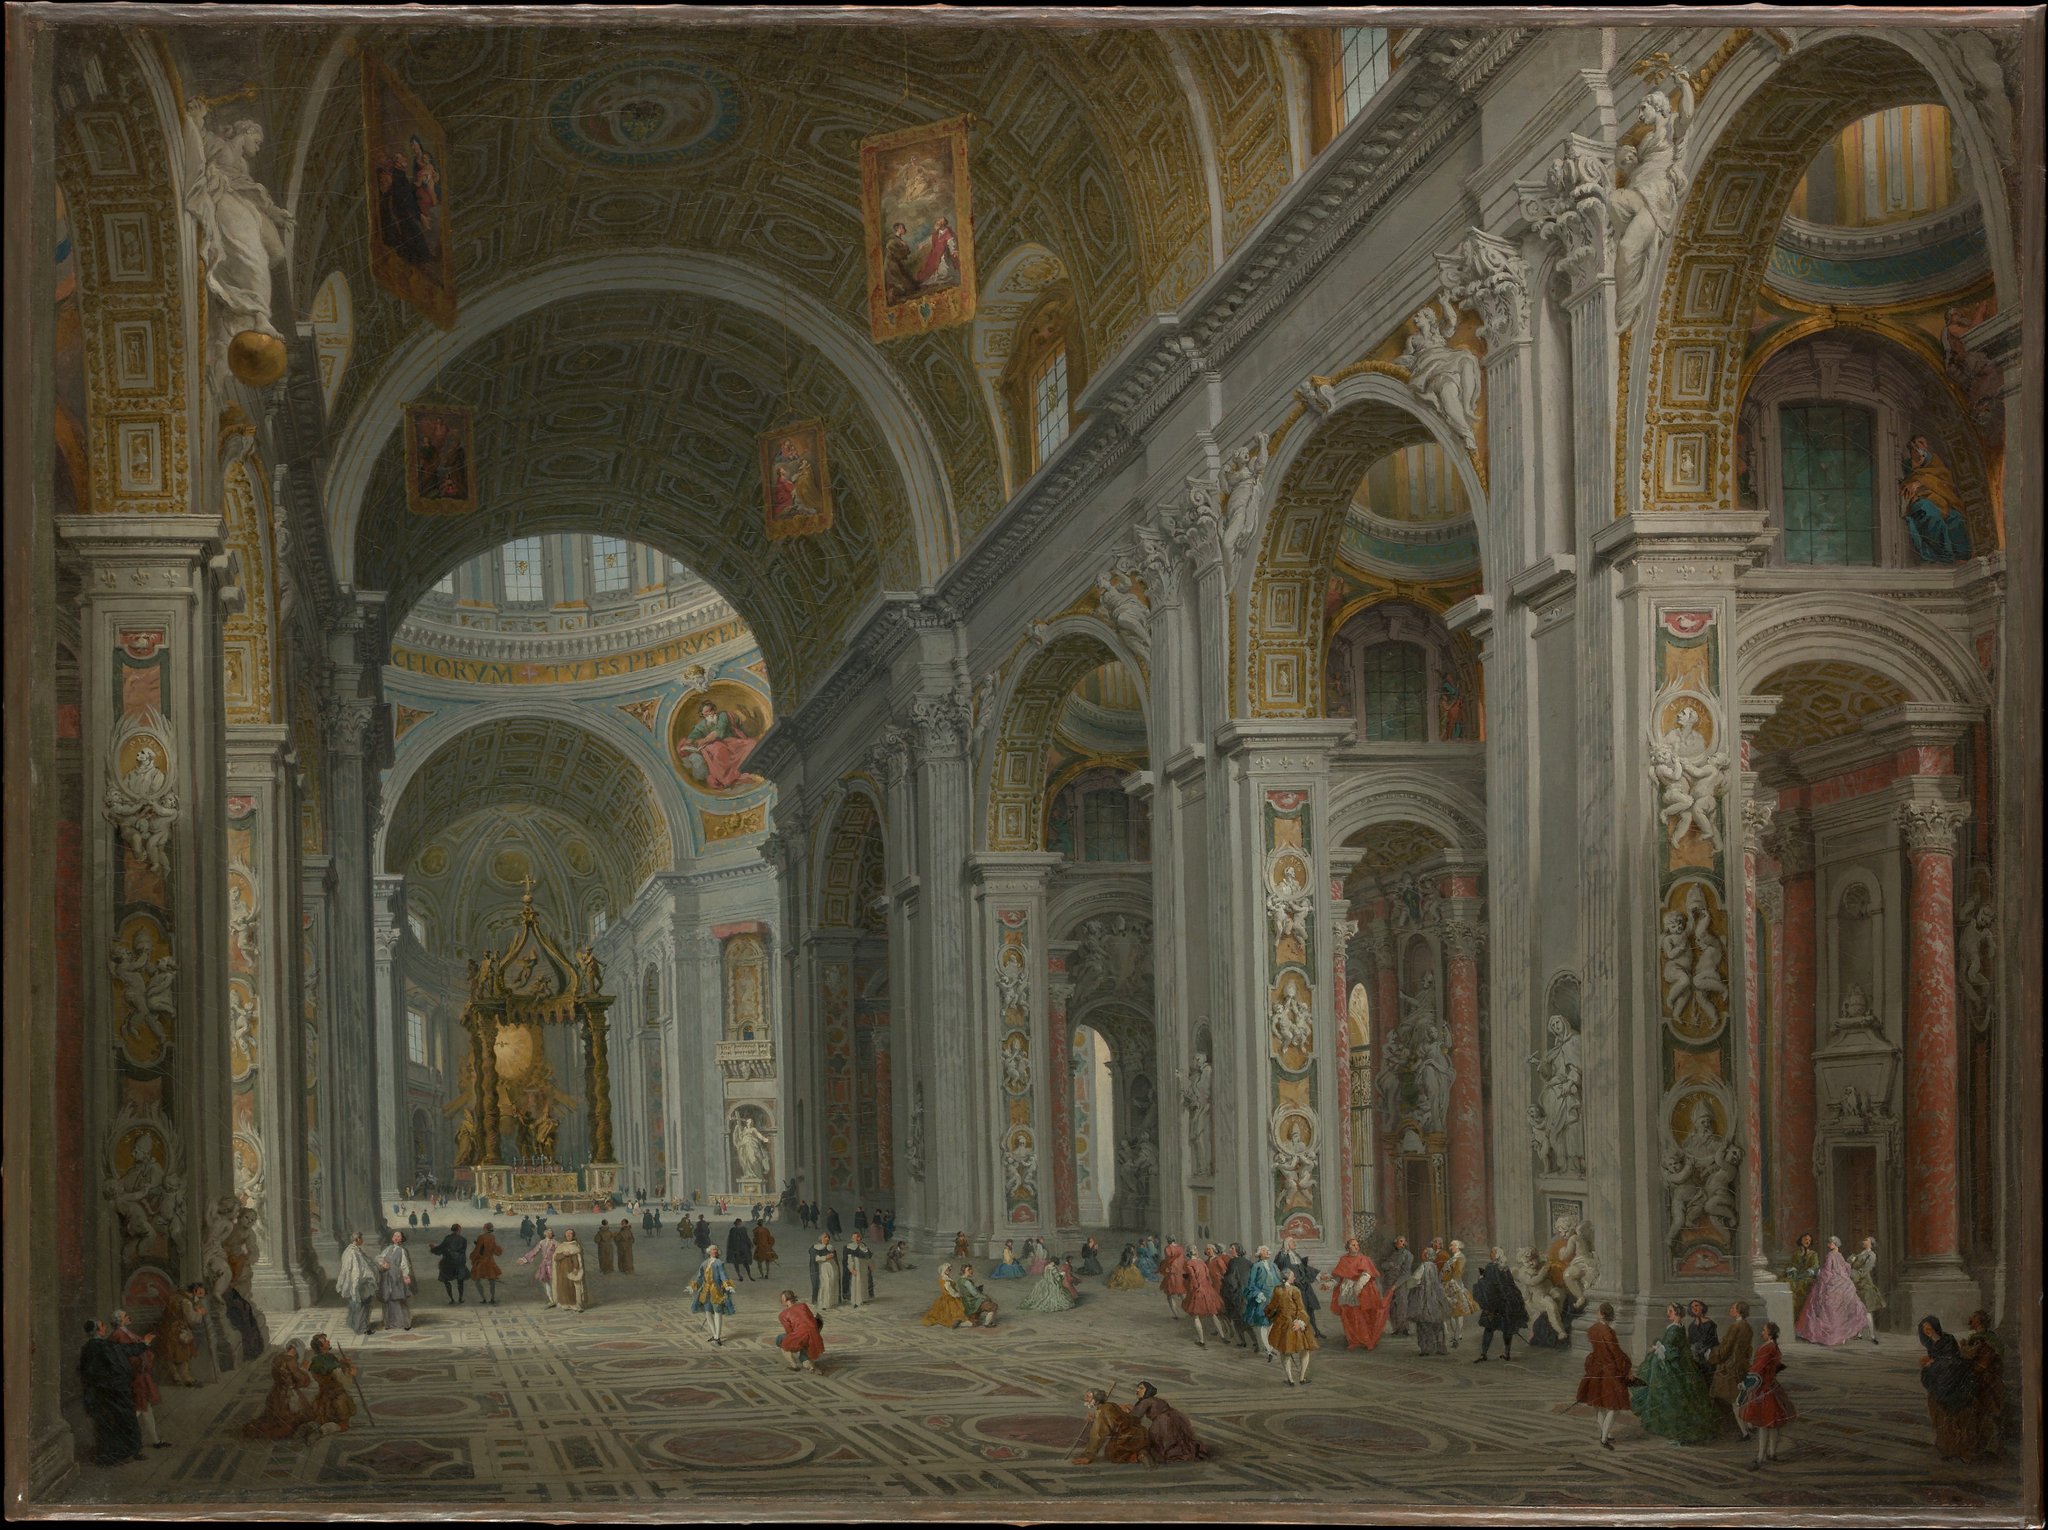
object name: painting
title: Interior of Saint Peter's, Rome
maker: giovanni paolo panini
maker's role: artist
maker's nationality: italian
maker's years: 1691-1765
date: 1754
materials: canvas, oil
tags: interiors,churches,crowd,rome